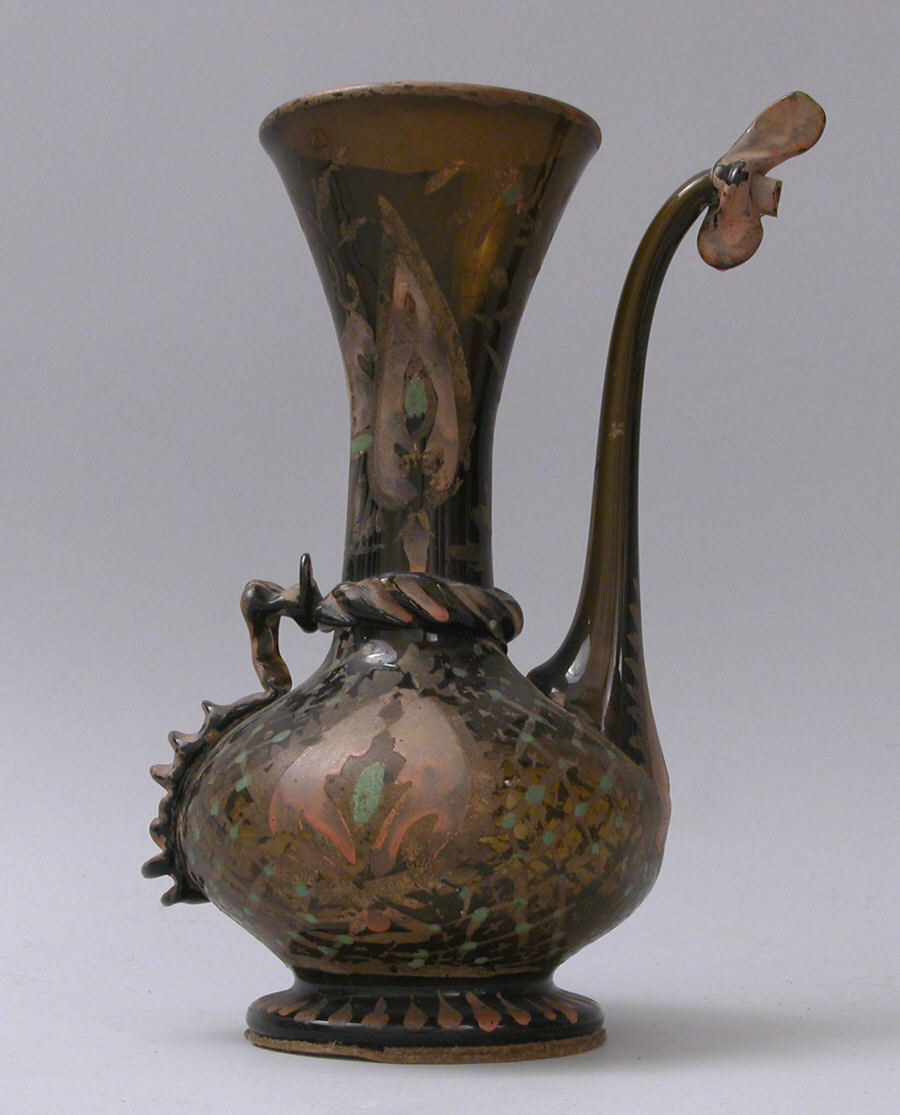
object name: ewer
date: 1701-1900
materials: glass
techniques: painting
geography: iran